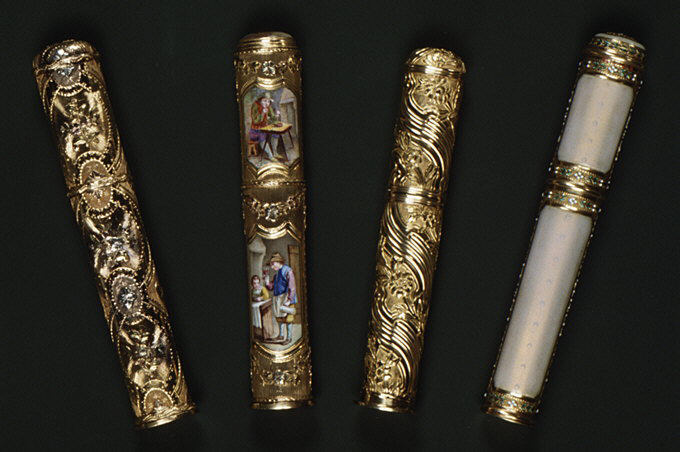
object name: étui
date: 1750-1756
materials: gold